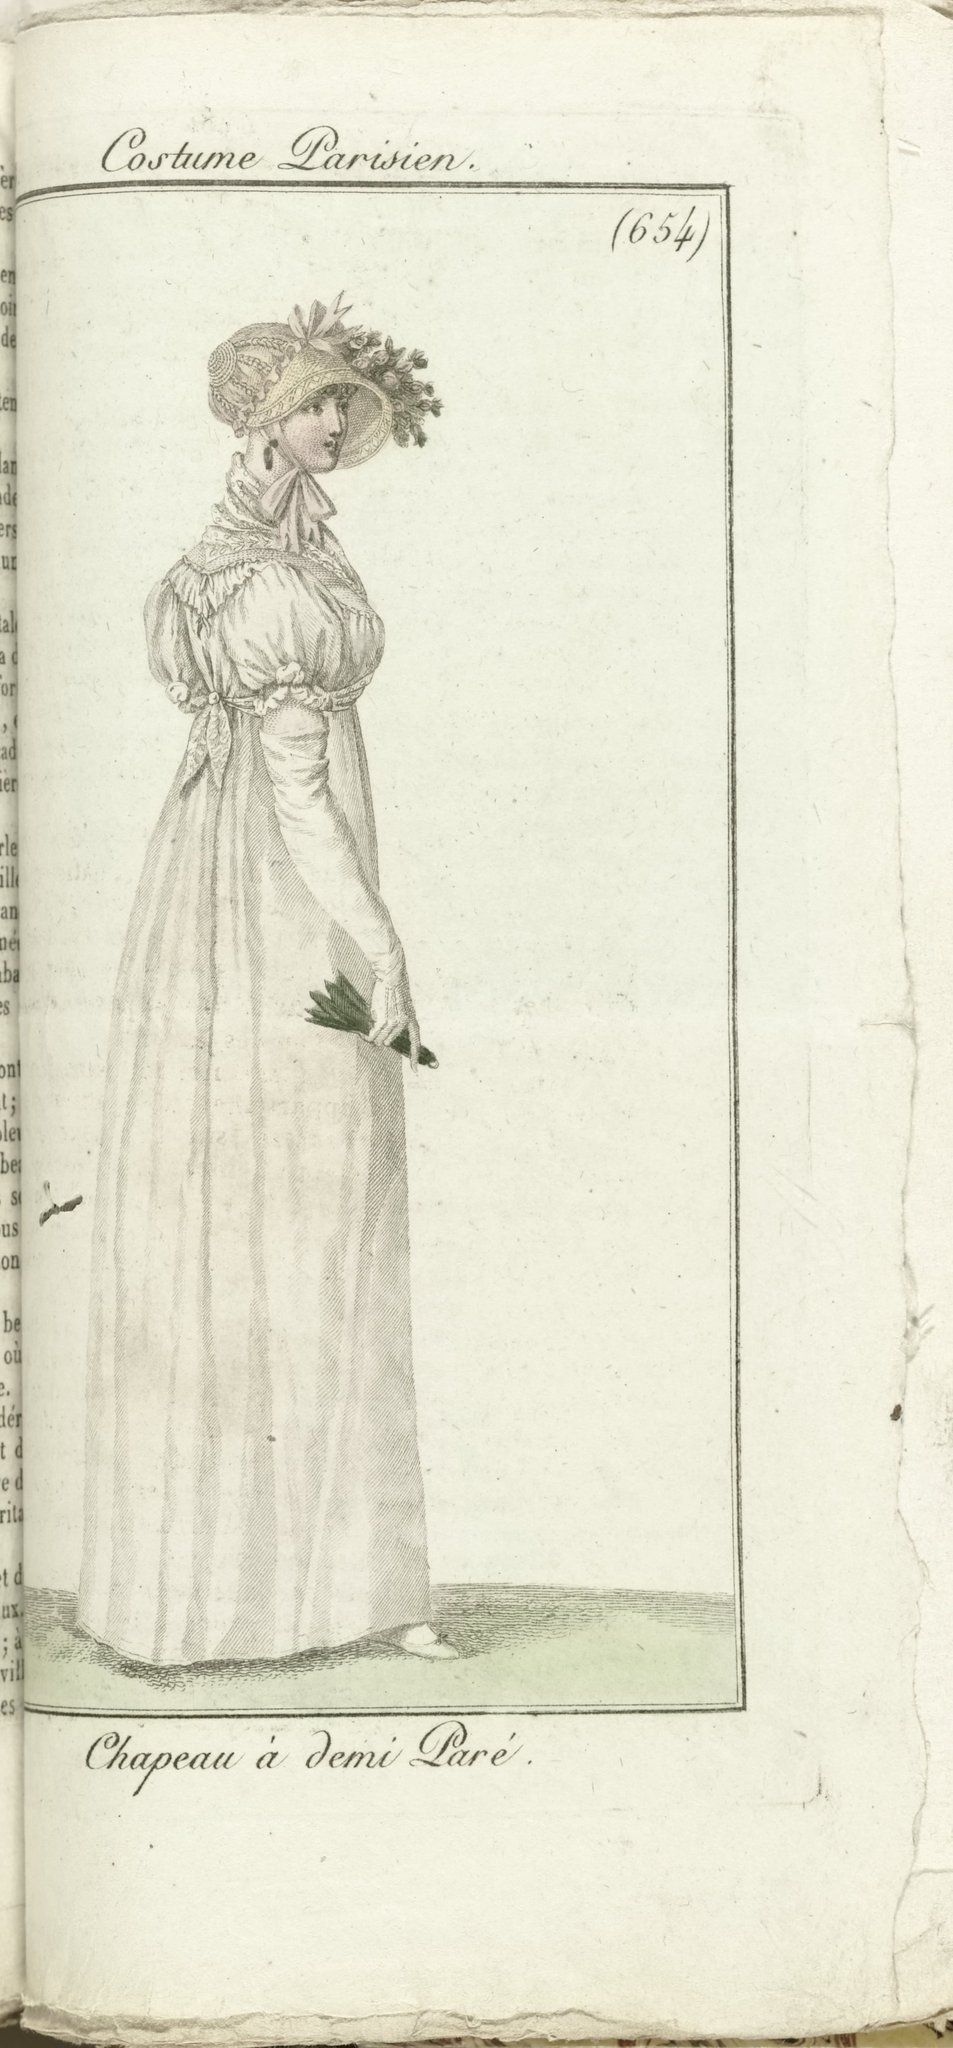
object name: fashion print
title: Journal des Dames et des Modes, Costume Parisien, 1805, An 13 (654) Chapeau à demi Paré.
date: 1805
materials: paper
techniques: engraving, hand coloring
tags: ear-rings (+ women's clothes), gloves, mittens (long gloves) (+ women's clothes), head-gear (straw hat) (+ women's clothes), fashion plates, dress, gown (+ women's clothes), fan (+ women's clothes)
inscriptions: title: ‘Chapeau à demi Paré.’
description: Vrouw naar rechts in witte japon met korte pofmouwen en halsdoek. Lange witte handschoenen. Oorbellen. In de hand een kleine waaier. Strohoed versierd met bloemen.